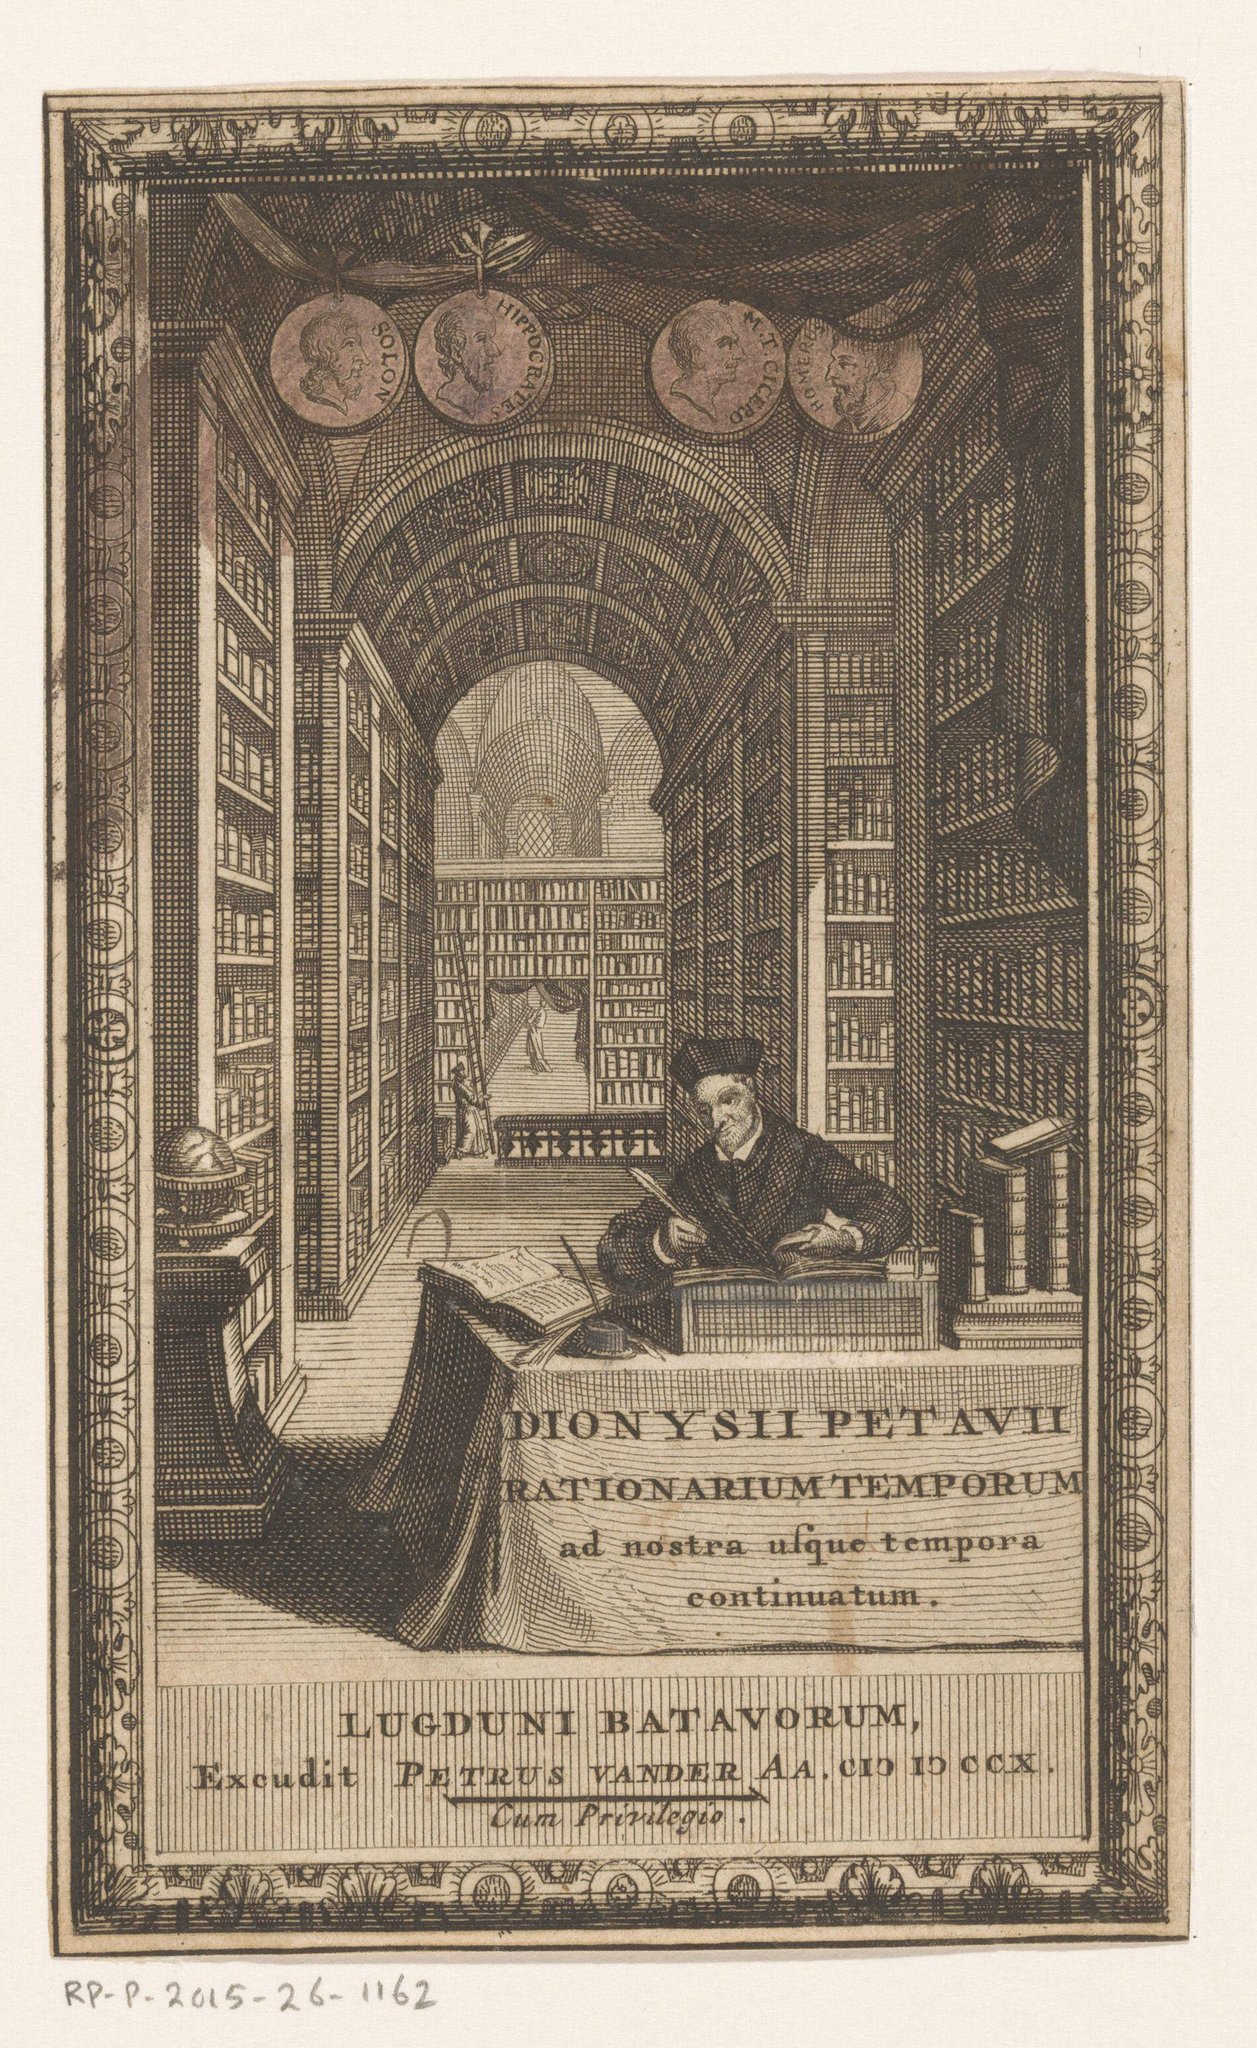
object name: print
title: Portret van Denis Pétau achter zijn schrijftafel in een bibliotheek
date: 1710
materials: paper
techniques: etching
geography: leiden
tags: paris, writing-table, writing-desk, public library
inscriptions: collector's mark: Lugt 4779, collector's mark: Lugt 2228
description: Boven de auteur hangen medaillons met portretten van Solon, Hippocrates, Cicero en Homerus. In de achtergrond staat een man met een ladder.